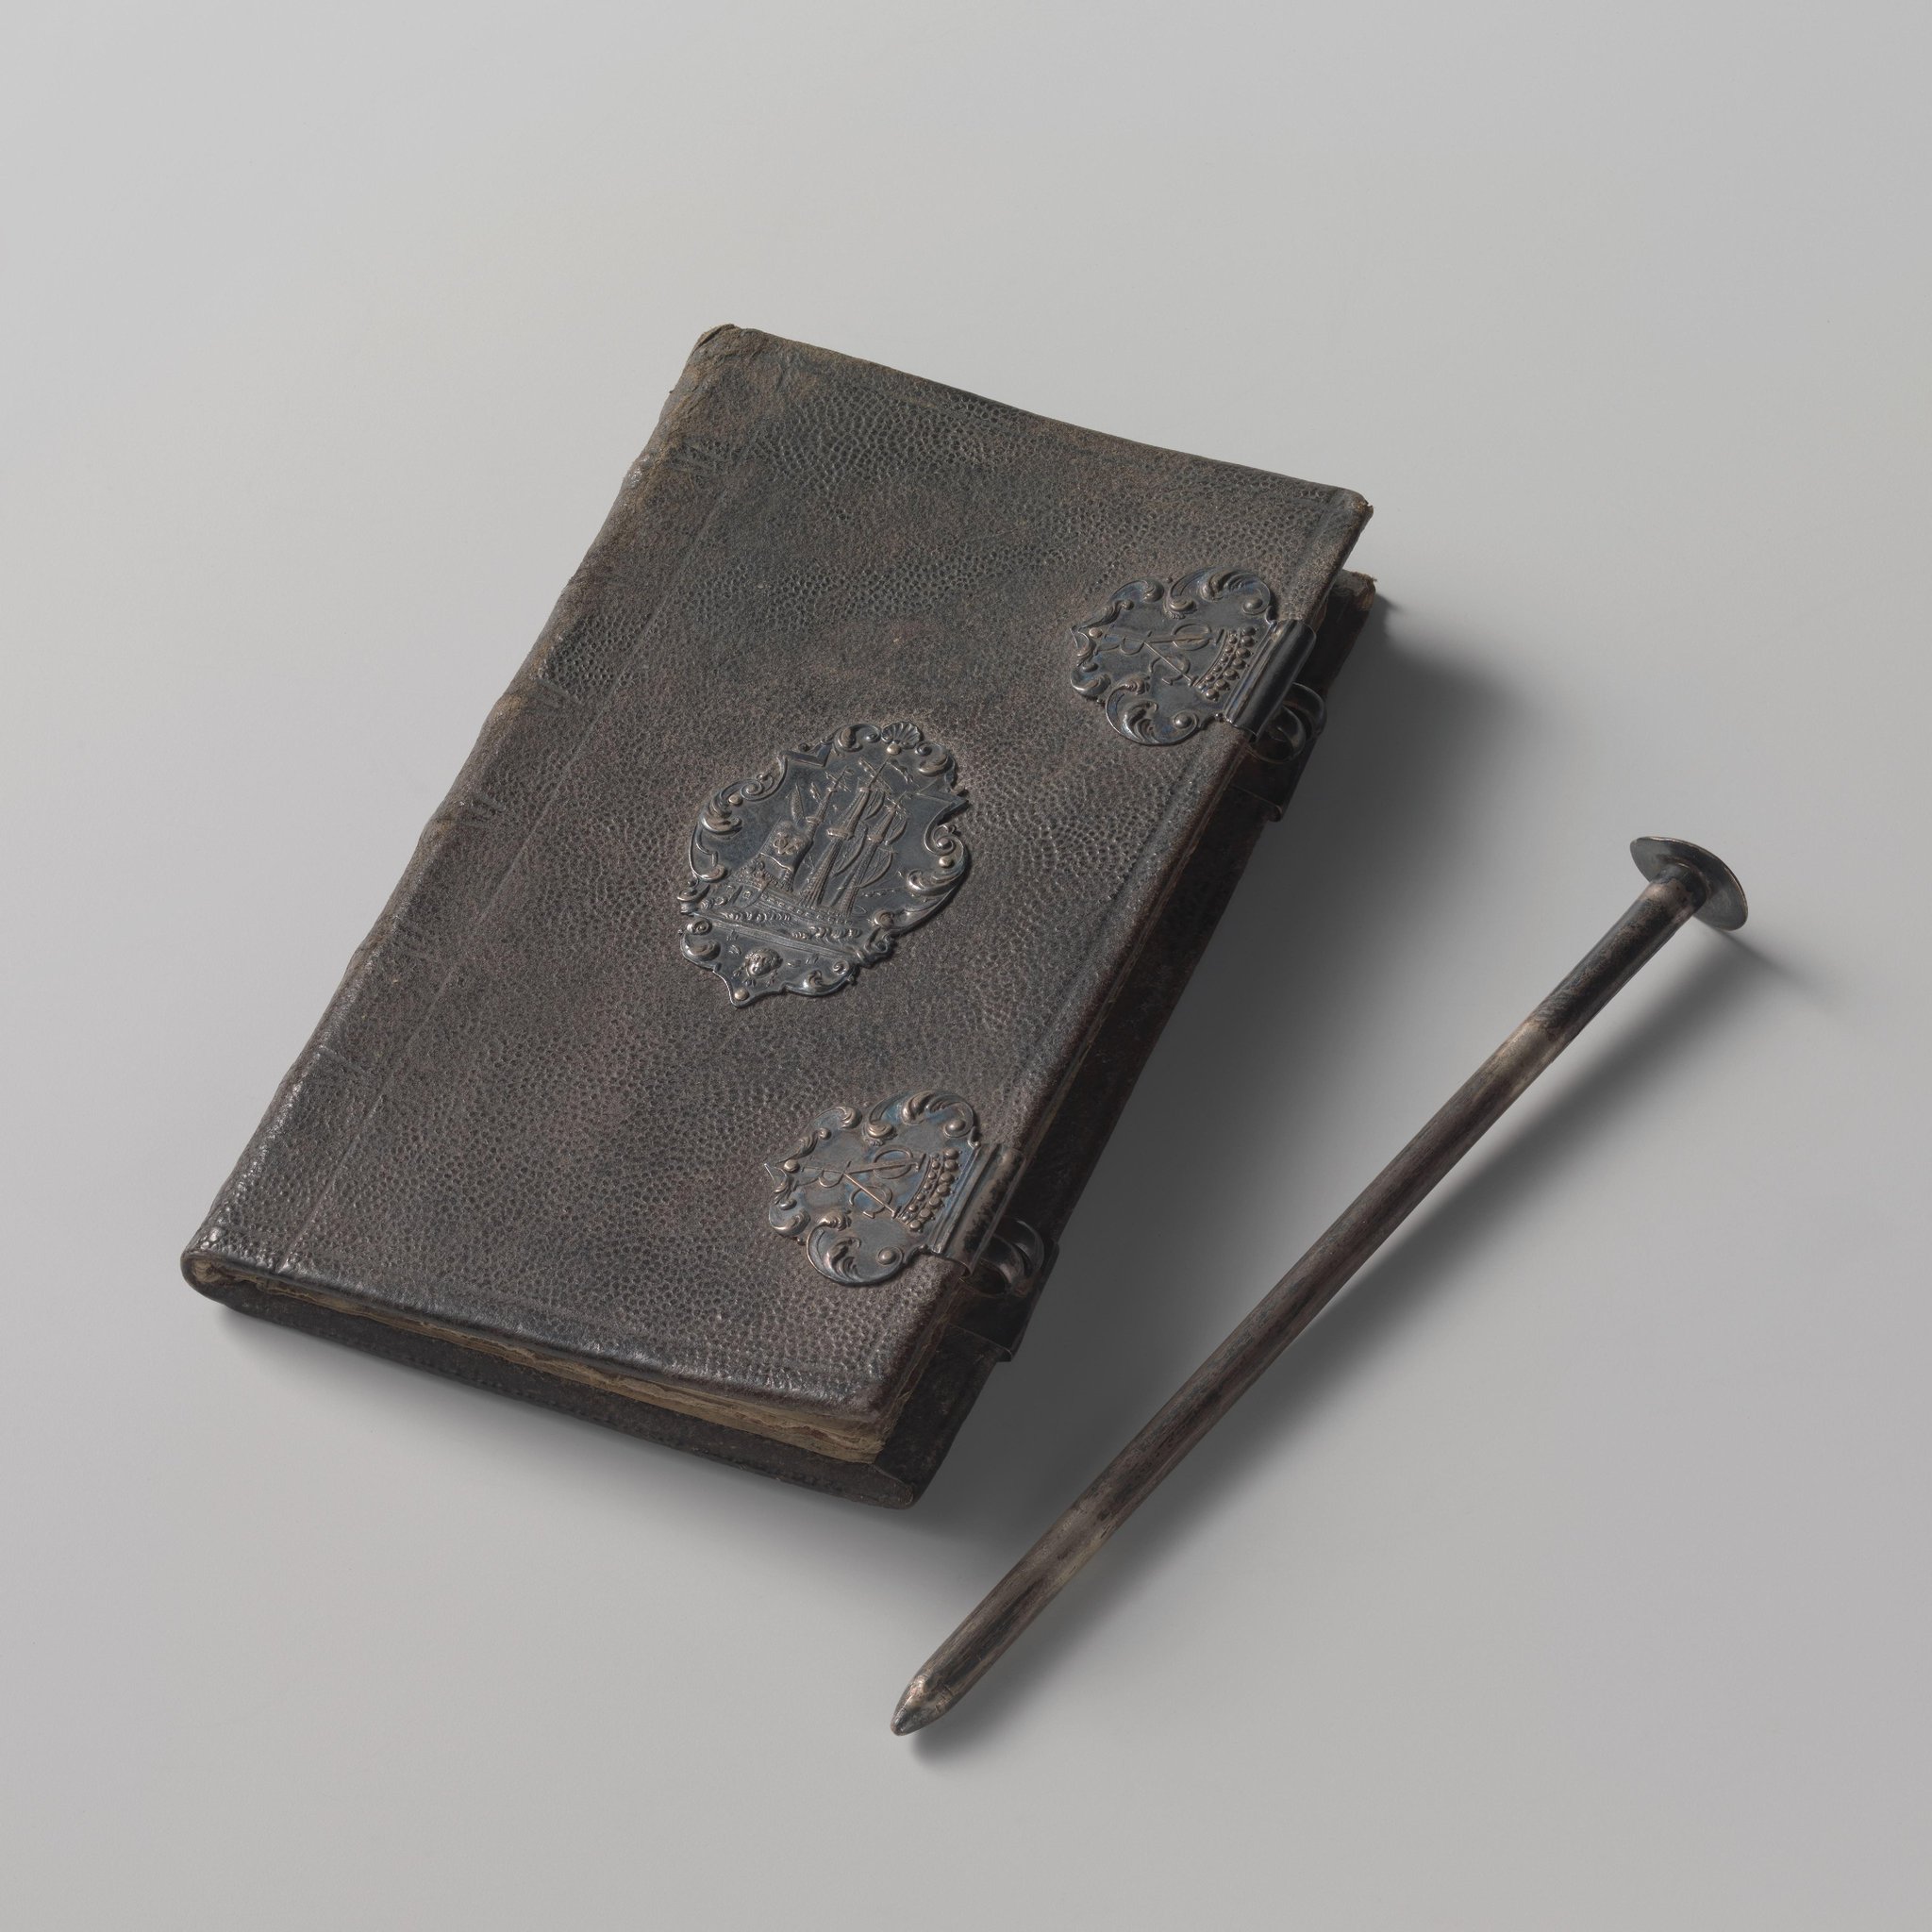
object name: notebook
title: Notitieboekje met bladen van perkament in zwart leren bandje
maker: Anonymous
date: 1700-1750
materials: leather, parchment, silver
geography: netherlands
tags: verenigde oostindische compagnie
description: Notitieboekje met bladen van perkament, in zwart leren bandje, waarop in het midden aan voor- en achterkant een schildje van zilver, waarop een schip met V.O.C.-vlag in reliëf, is aangebracht. Het boekje heeft twee maal twee klampen van zilver, waarop in reliëf VOC en R onder kroon (kamer Rotterdam van de V.O.C.) In de ringen van de klampen is een zilveren schrijfstift gestoken.